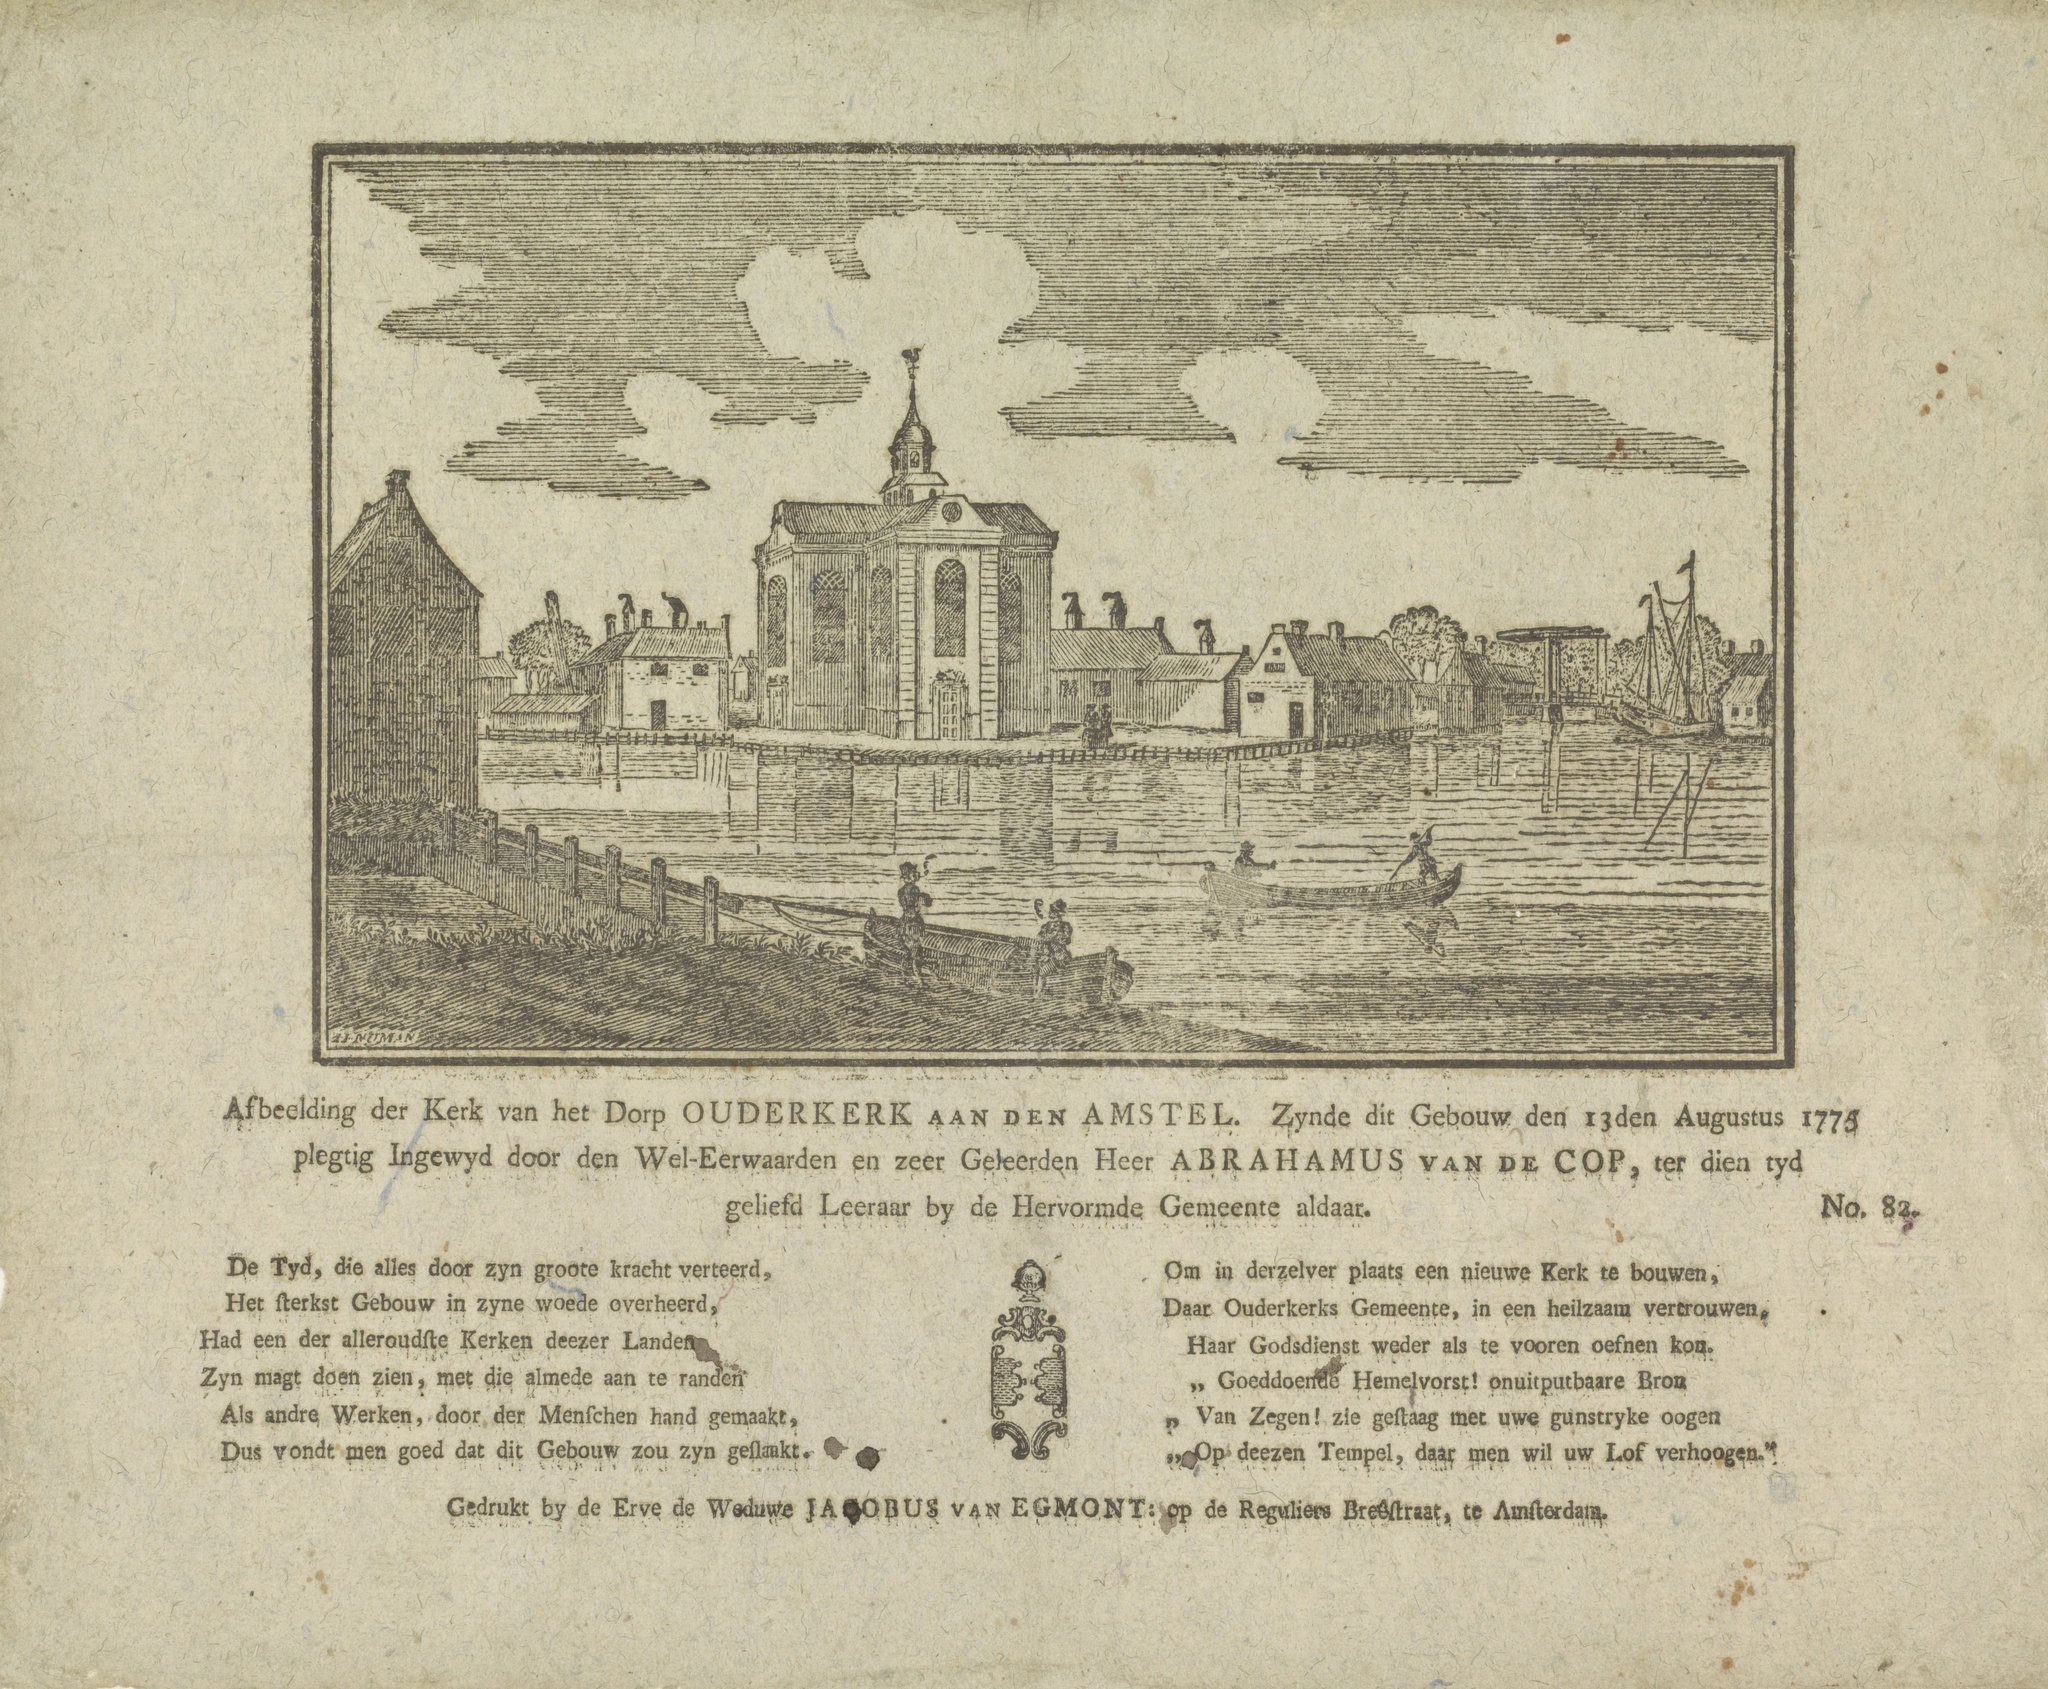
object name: popular print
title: Afbeelding der kerk van het dorp Ouderkerk aan den Amstel [(...)]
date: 1761-1804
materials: paper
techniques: letterpress printing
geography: amsterdam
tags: church (exterior)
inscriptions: collector's mark: Lugt 2760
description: Blad met grote voorstelling van de kerk van Ouderkerk aan de Amstel. Onder de voorstelling een twaalfregelig vers in twee kolommen. Genummerd midden rechts: No. 82.